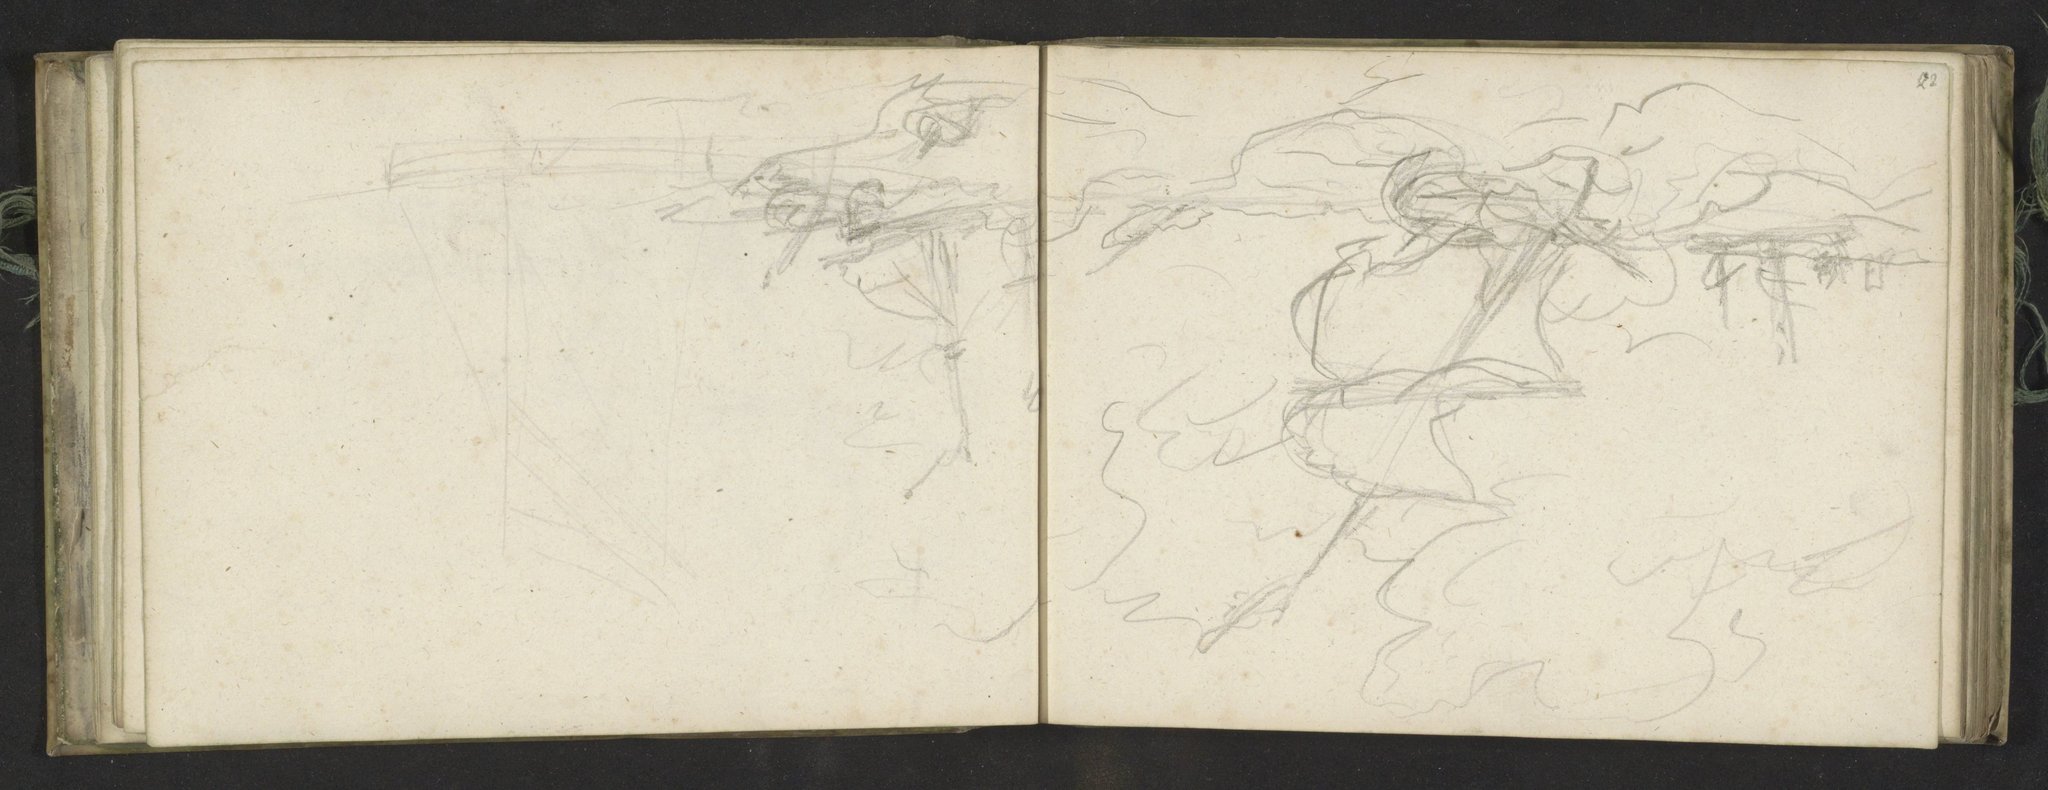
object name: sketchbook leaf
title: Zeilschepen op het water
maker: martinus schouman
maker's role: draughtsman, painter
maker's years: 1770-1848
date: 1780-1848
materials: paper, pencil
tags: sailing-ship, sailing-boat, landscapes with waters, waterscapes, seascapes (in the temperate zone)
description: Blad 21 verso en 22 recto uit een schetsboek met 53 bladen.